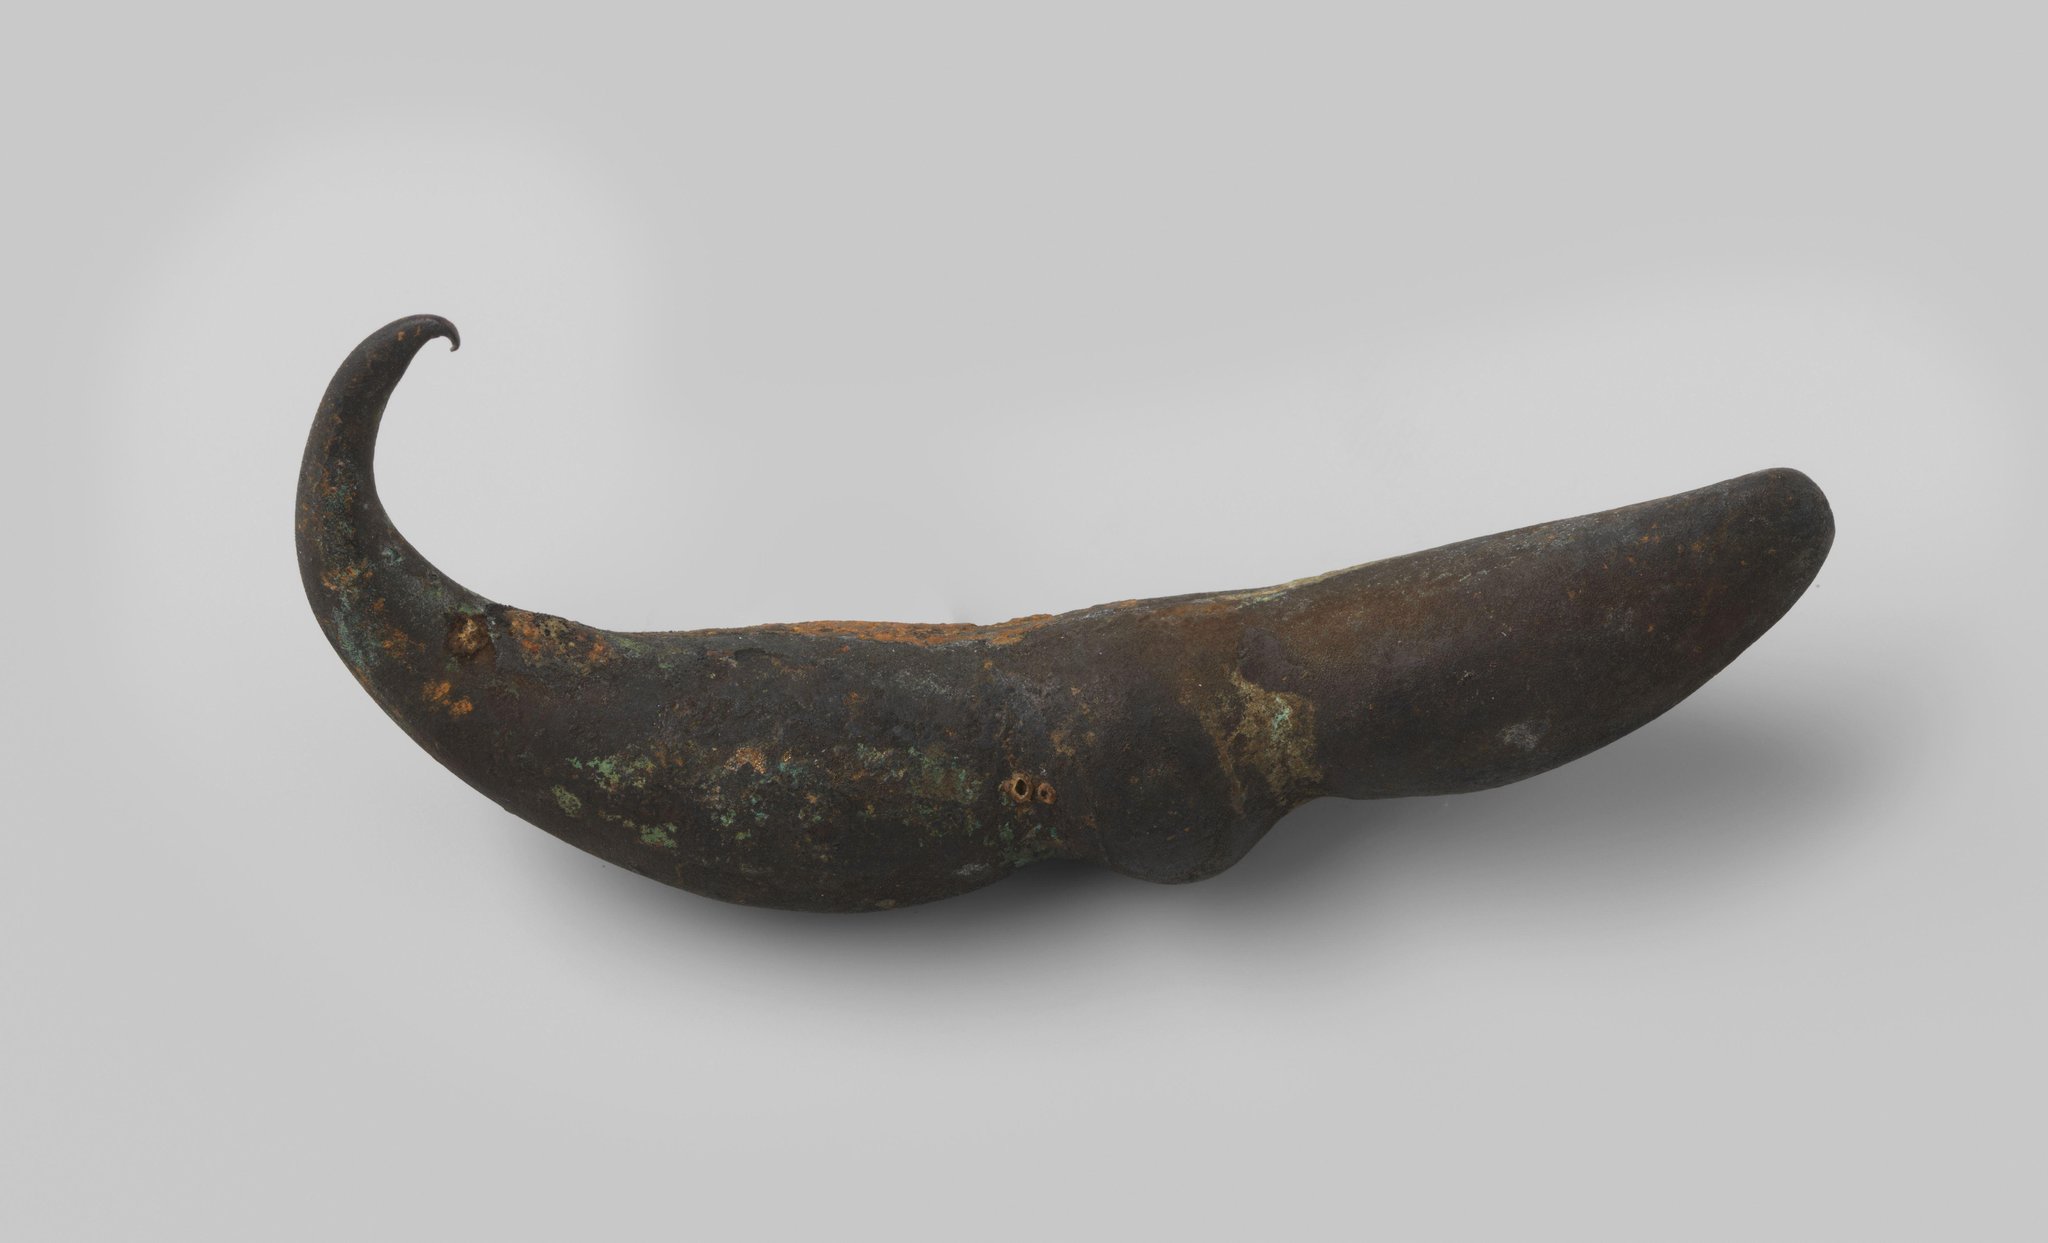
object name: borgpen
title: Borgpen uit het wrak van de Oost-Indiëvaarder Meresteijn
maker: Anonymous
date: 1693-1702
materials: copper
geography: netherlands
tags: cape of good hope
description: Koperen borgpen, massief rond in het midden versmallend, éen uiteinde is een kromme punt. Hoort bij de borgring NG-1975-79B-ME. De pen werd door de ring geslagen die bijvoorbeeld aan een kist was bevestigd. De kromme punt van de pen haakte dan in de deksel en hield deze op zijn plaats. Bail handle.